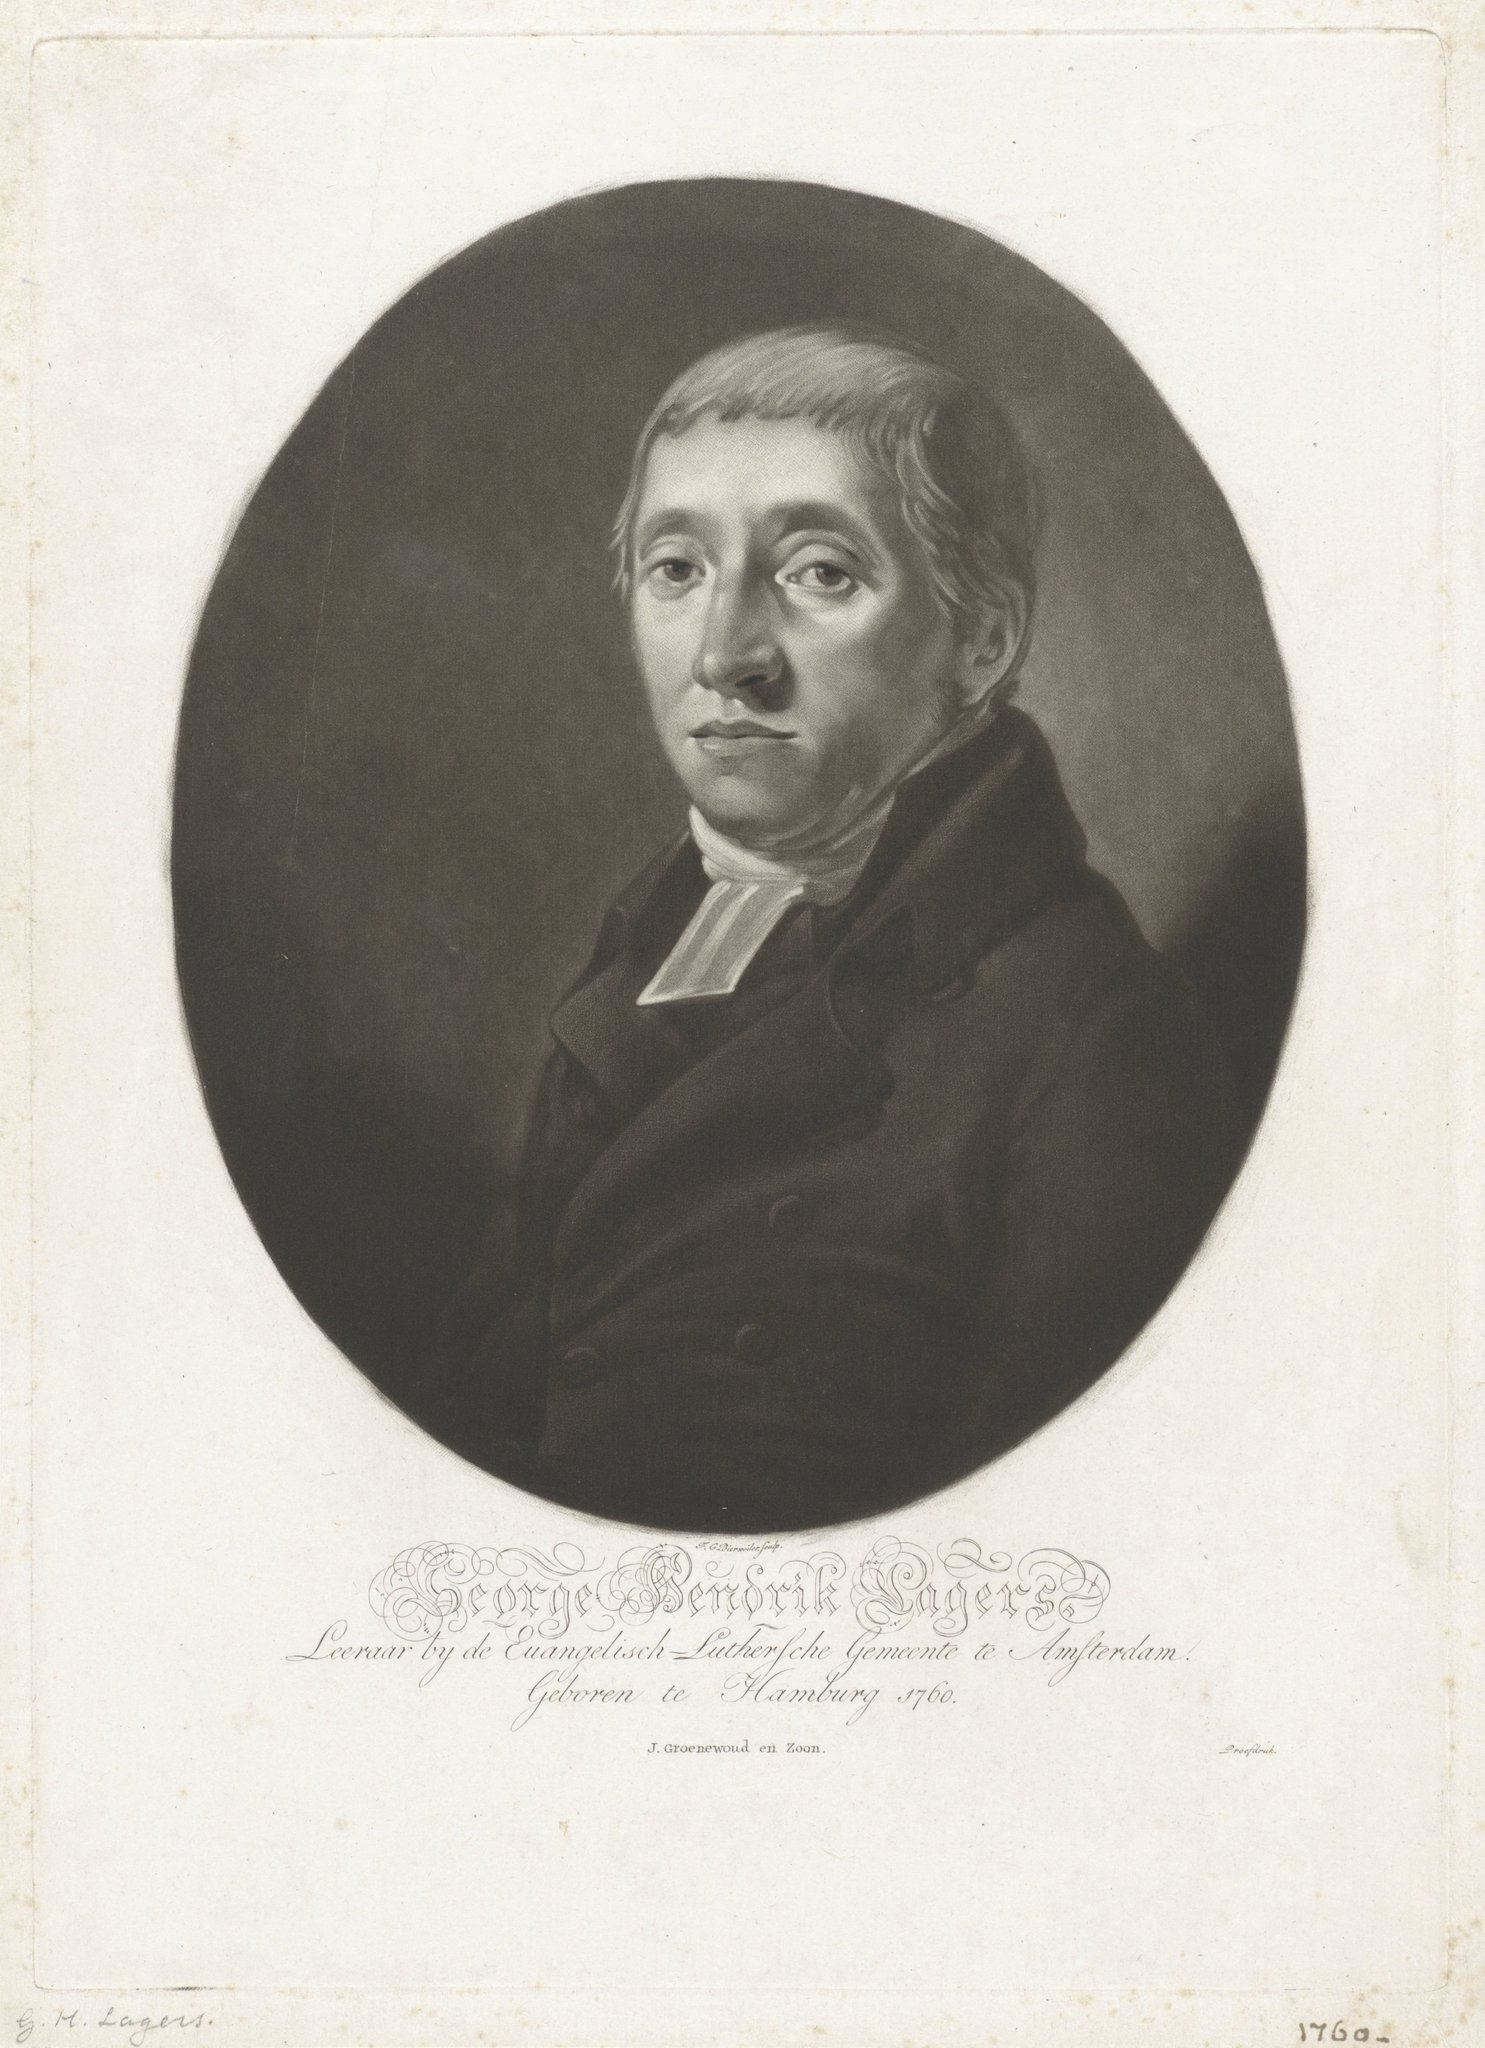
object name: print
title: Portret van George Hendrik Lagers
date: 1793-1833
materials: paper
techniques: engraving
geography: amsterdam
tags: amsterdam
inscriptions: collector's mark: Lugt 2228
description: Portret van George Hendrik Lagers, predikant van de Evangelisch Lutherse Gemeente in verschillende steden waaronder Kampen en Amsterdam.